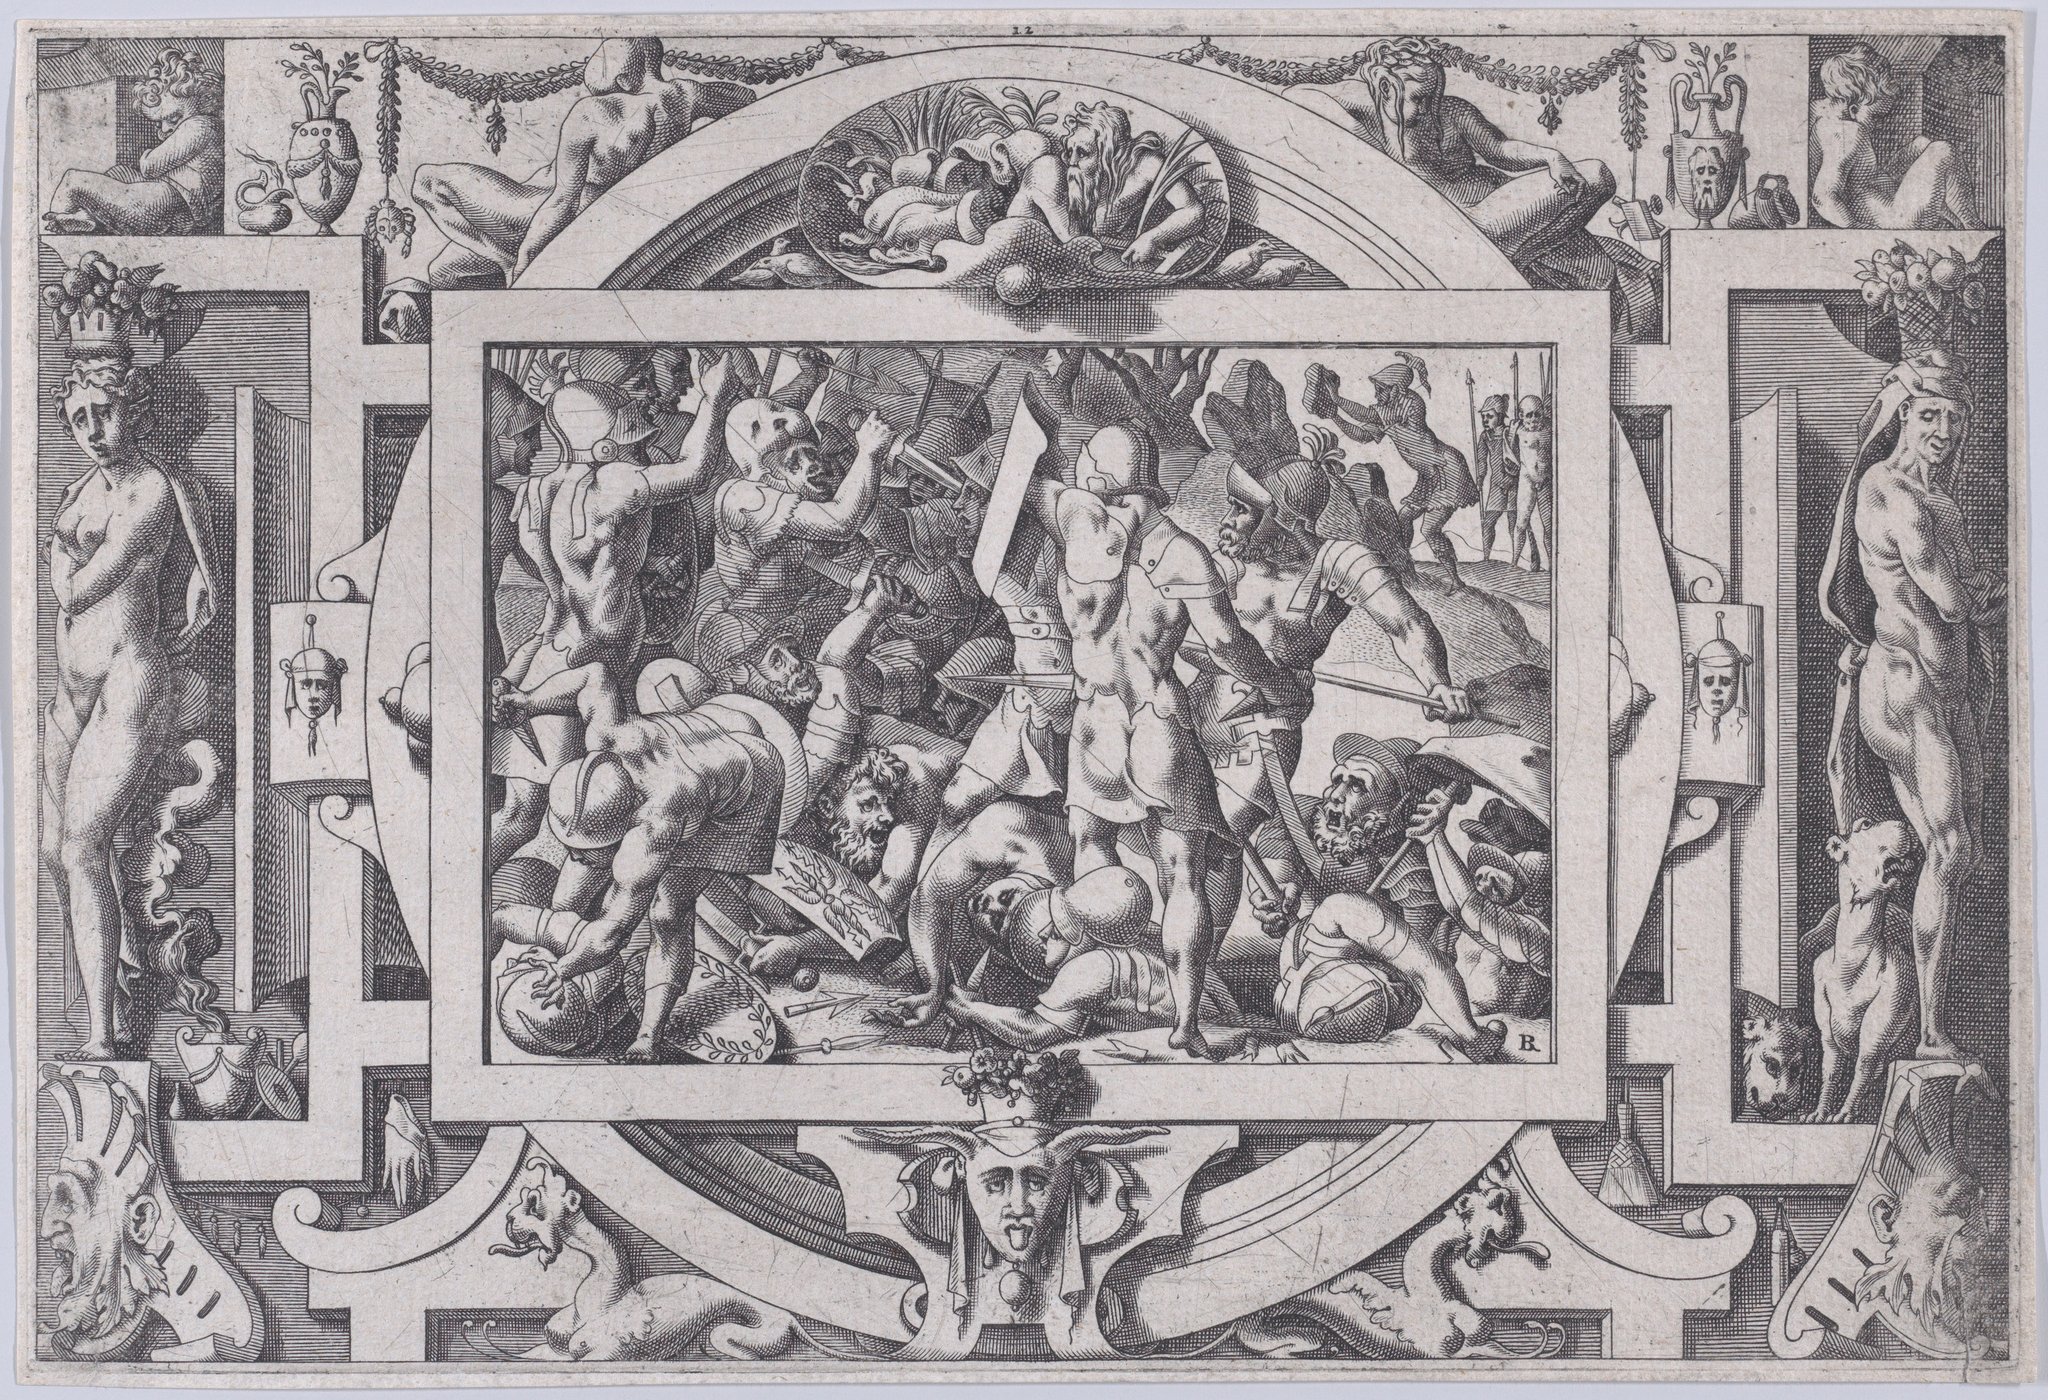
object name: print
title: Jason Throws a Rock at the Giants (Cette moisson va son semeur chercher a fer tranchant...), from "Jason and the Golden Fleece"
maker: rené boyvin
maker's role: artist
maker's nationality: french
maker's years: 1525-1598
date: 1563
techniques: engraving